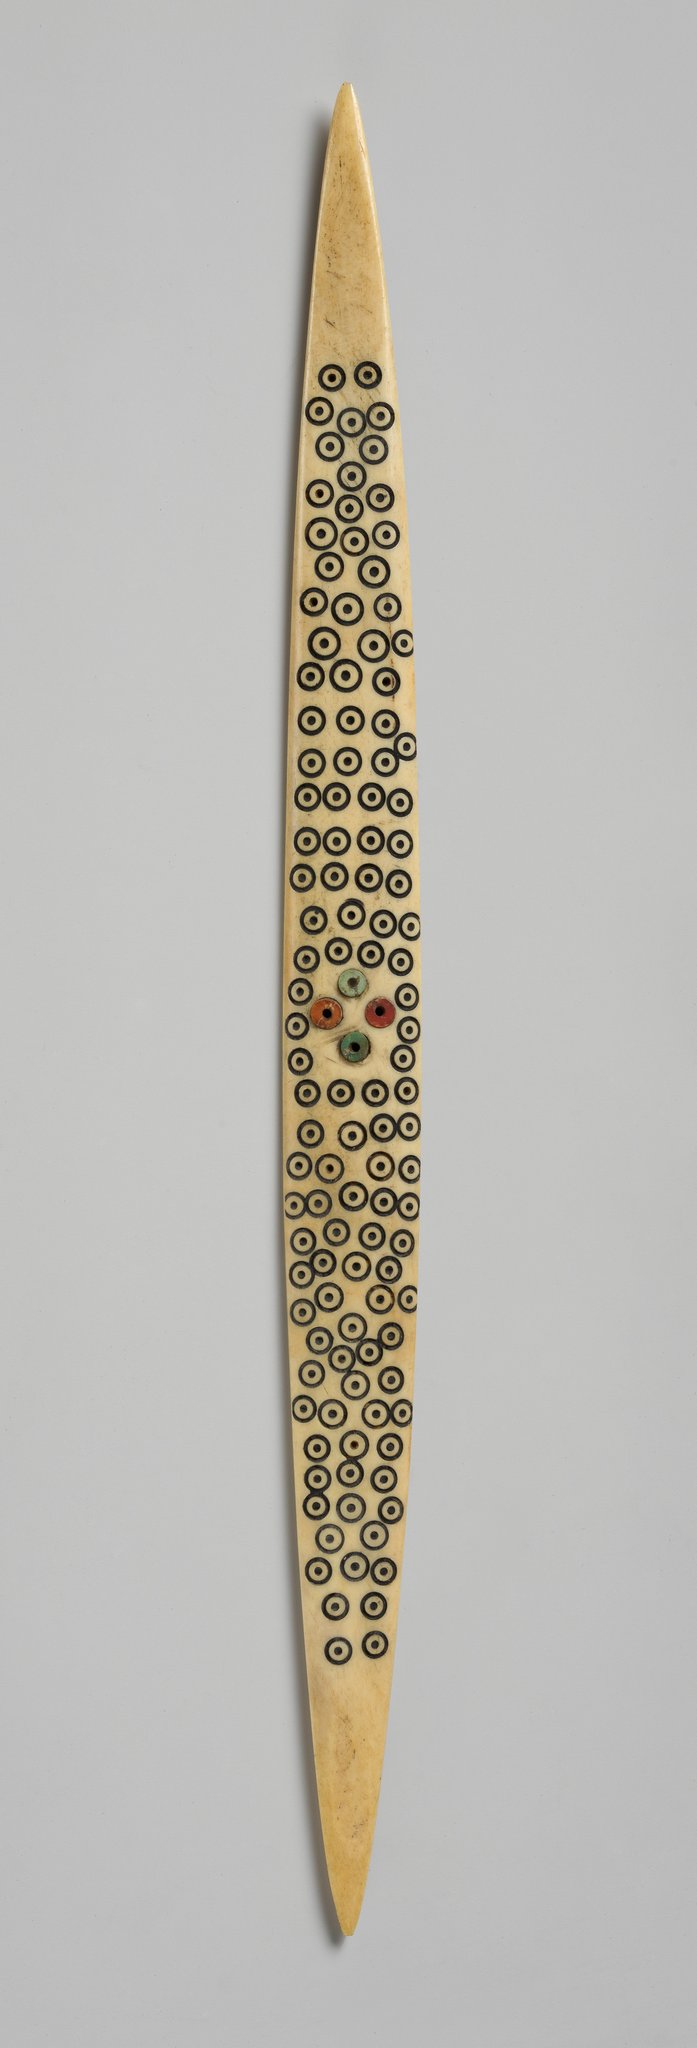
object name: weaving tool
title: Weaving Sword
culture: peruvian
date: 901-1600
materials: bone, shell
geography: peru